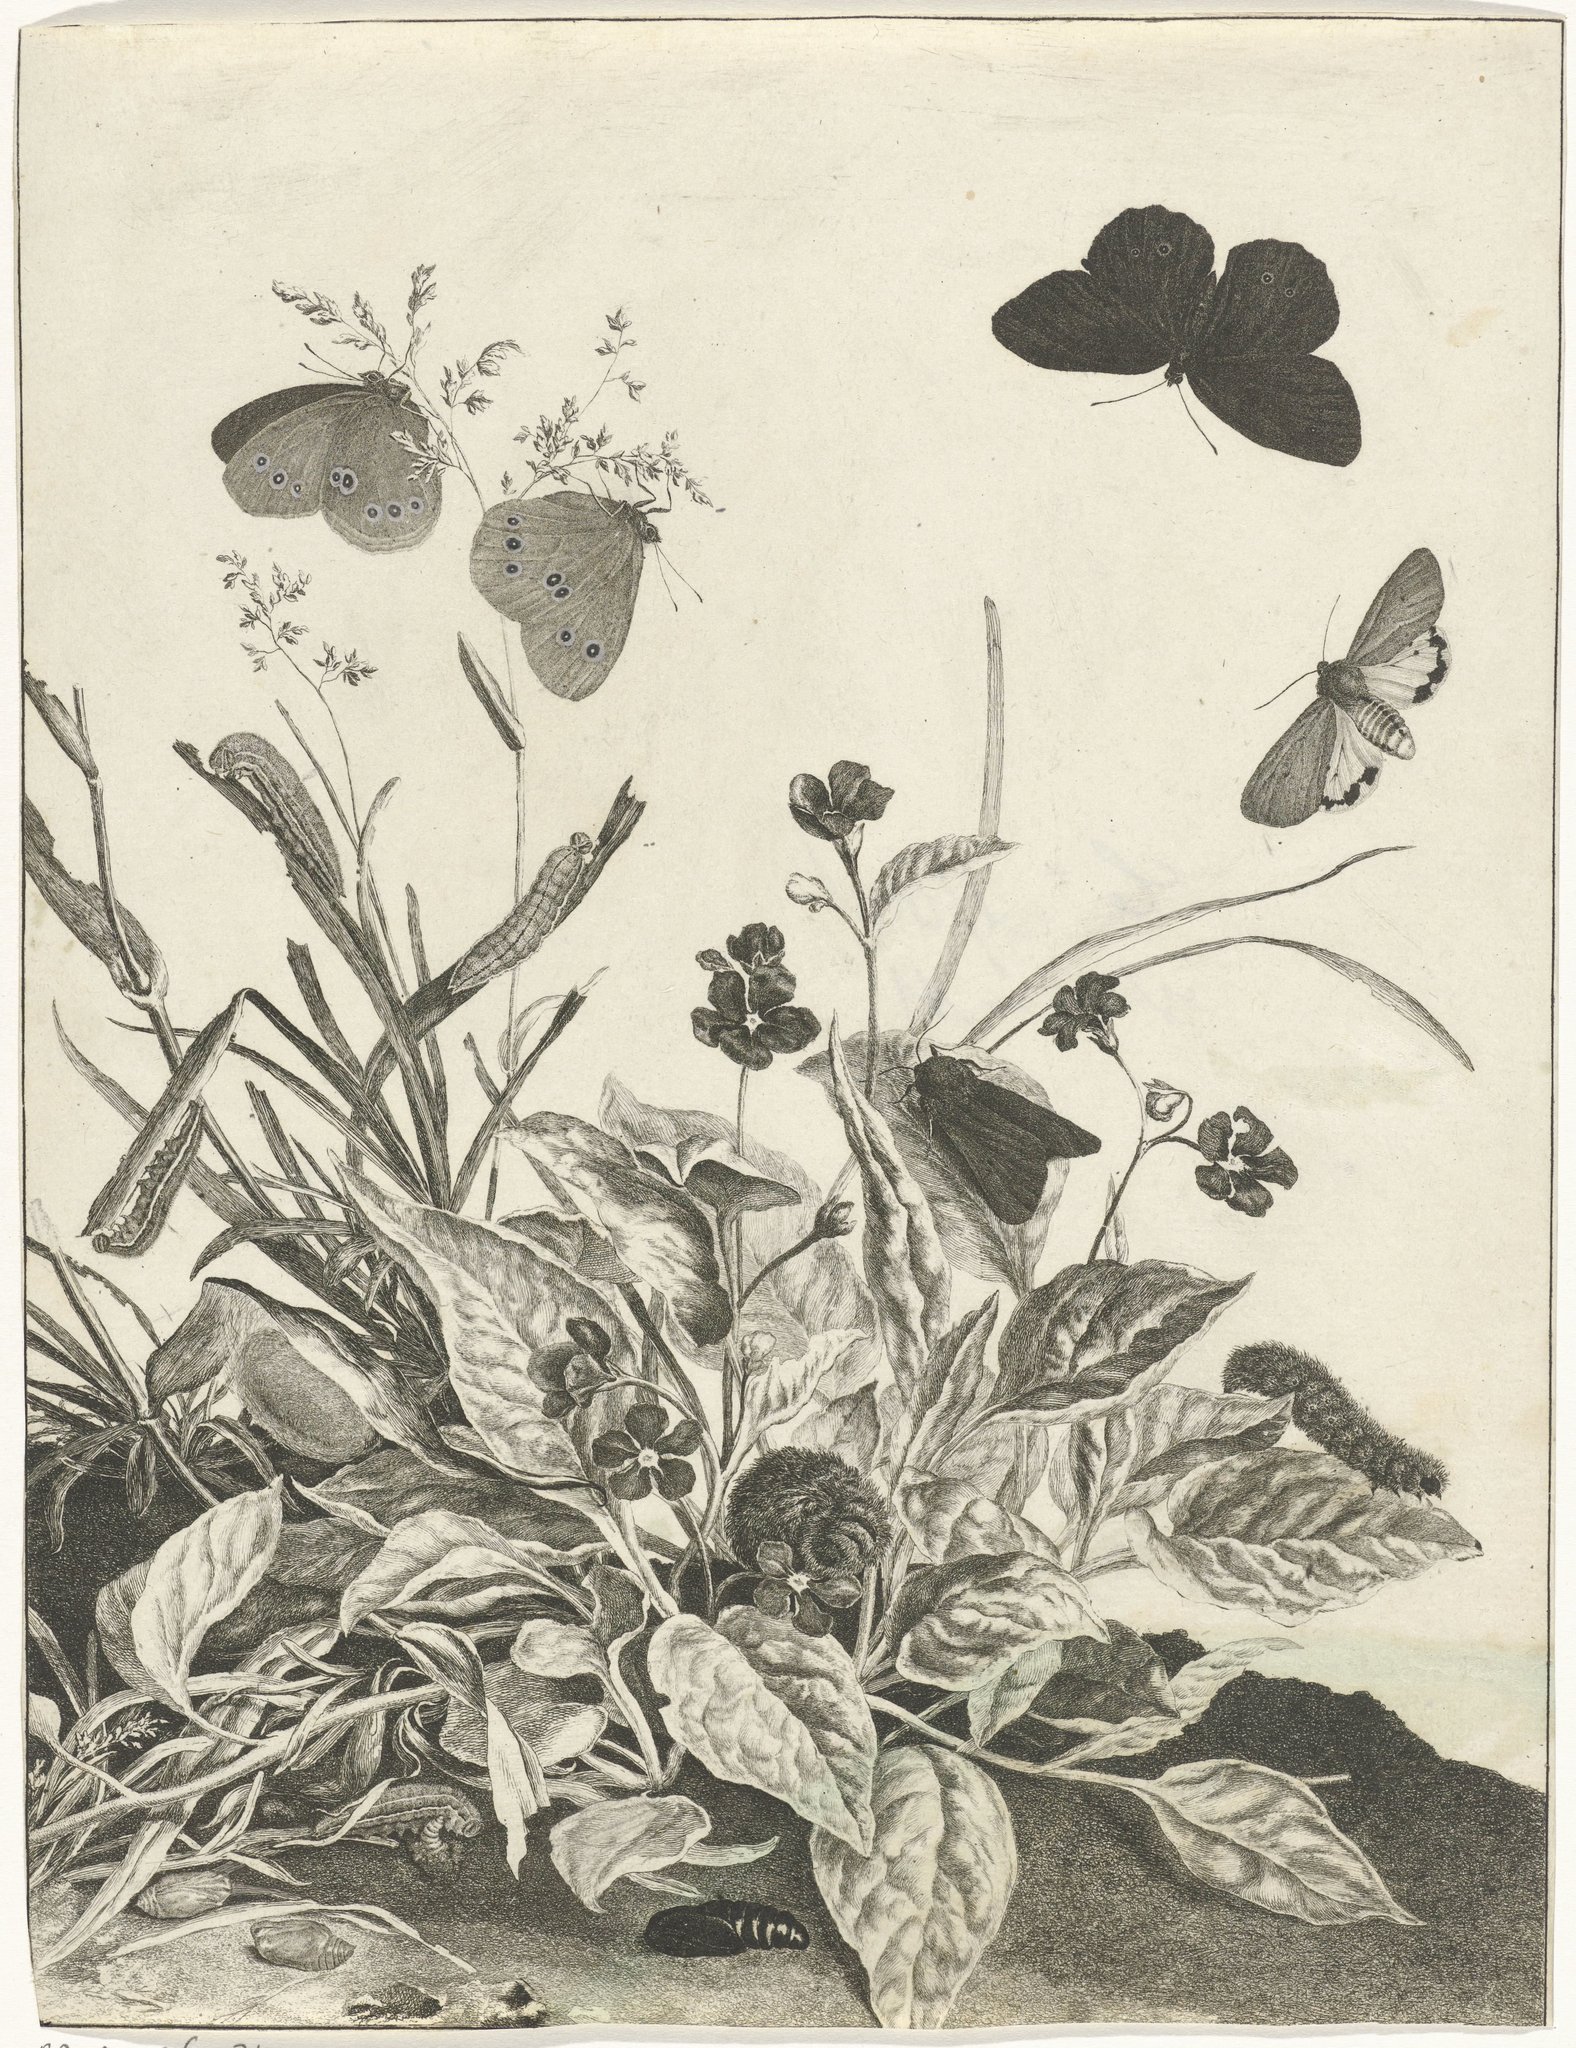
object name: print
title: Planten met vlinders en rupsen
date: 1710-1770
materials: paper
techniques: brush, etching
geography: amsterdam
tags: plants; vegetation, scallop, shell ~ ornament, insects: butterfly, insects: caterpillar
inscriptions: collector's mark: Lugt 2228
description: Prent gebruikt in: L'Admiral, Jacob. Naauwkeurige waarneemingen omtrent de veranderingen van veele insekten of gekorvene diertjes. Amsterdam: Johannes Sluyter, 1774.